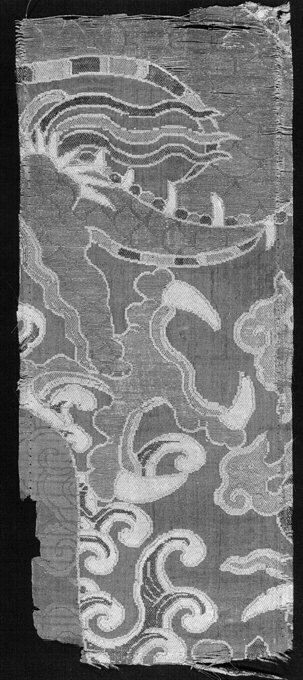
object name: sutra cover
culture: chinese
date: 1501-1700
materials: metal thread, silk